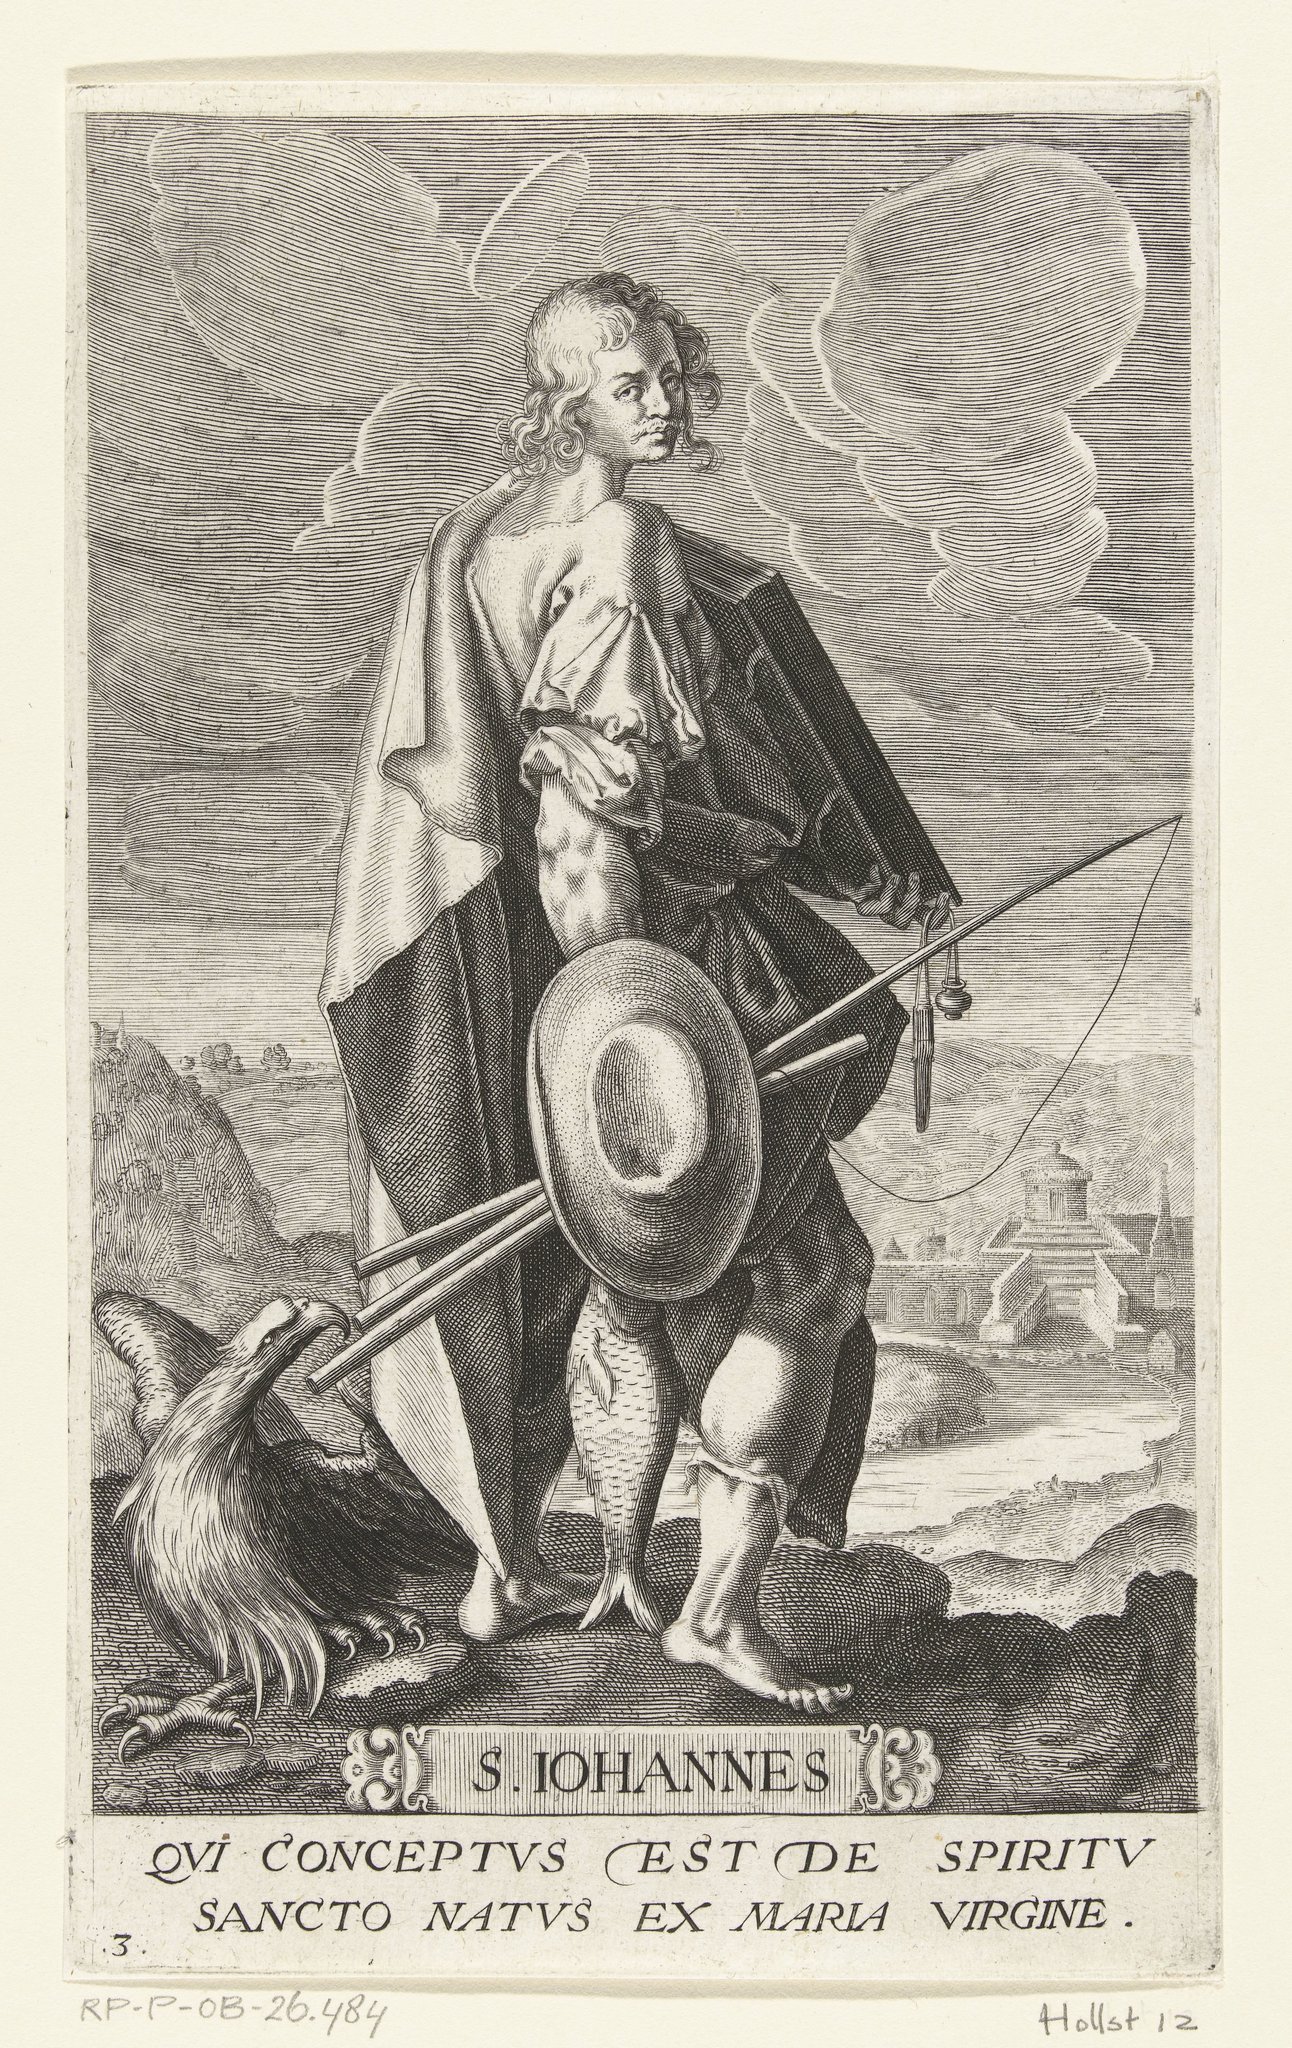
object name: print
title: S. Iohannes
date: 1591-1629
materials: paper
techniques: engraving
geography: prague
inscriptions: collector's mark: Lugt 2228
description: Apostel en evangelist Johannes staat met boek en vishengel met gevangen vis naast adelaar. Onder de voorstelling staat een Latijnse regel uit de apostolische geloofsbelijdenis.